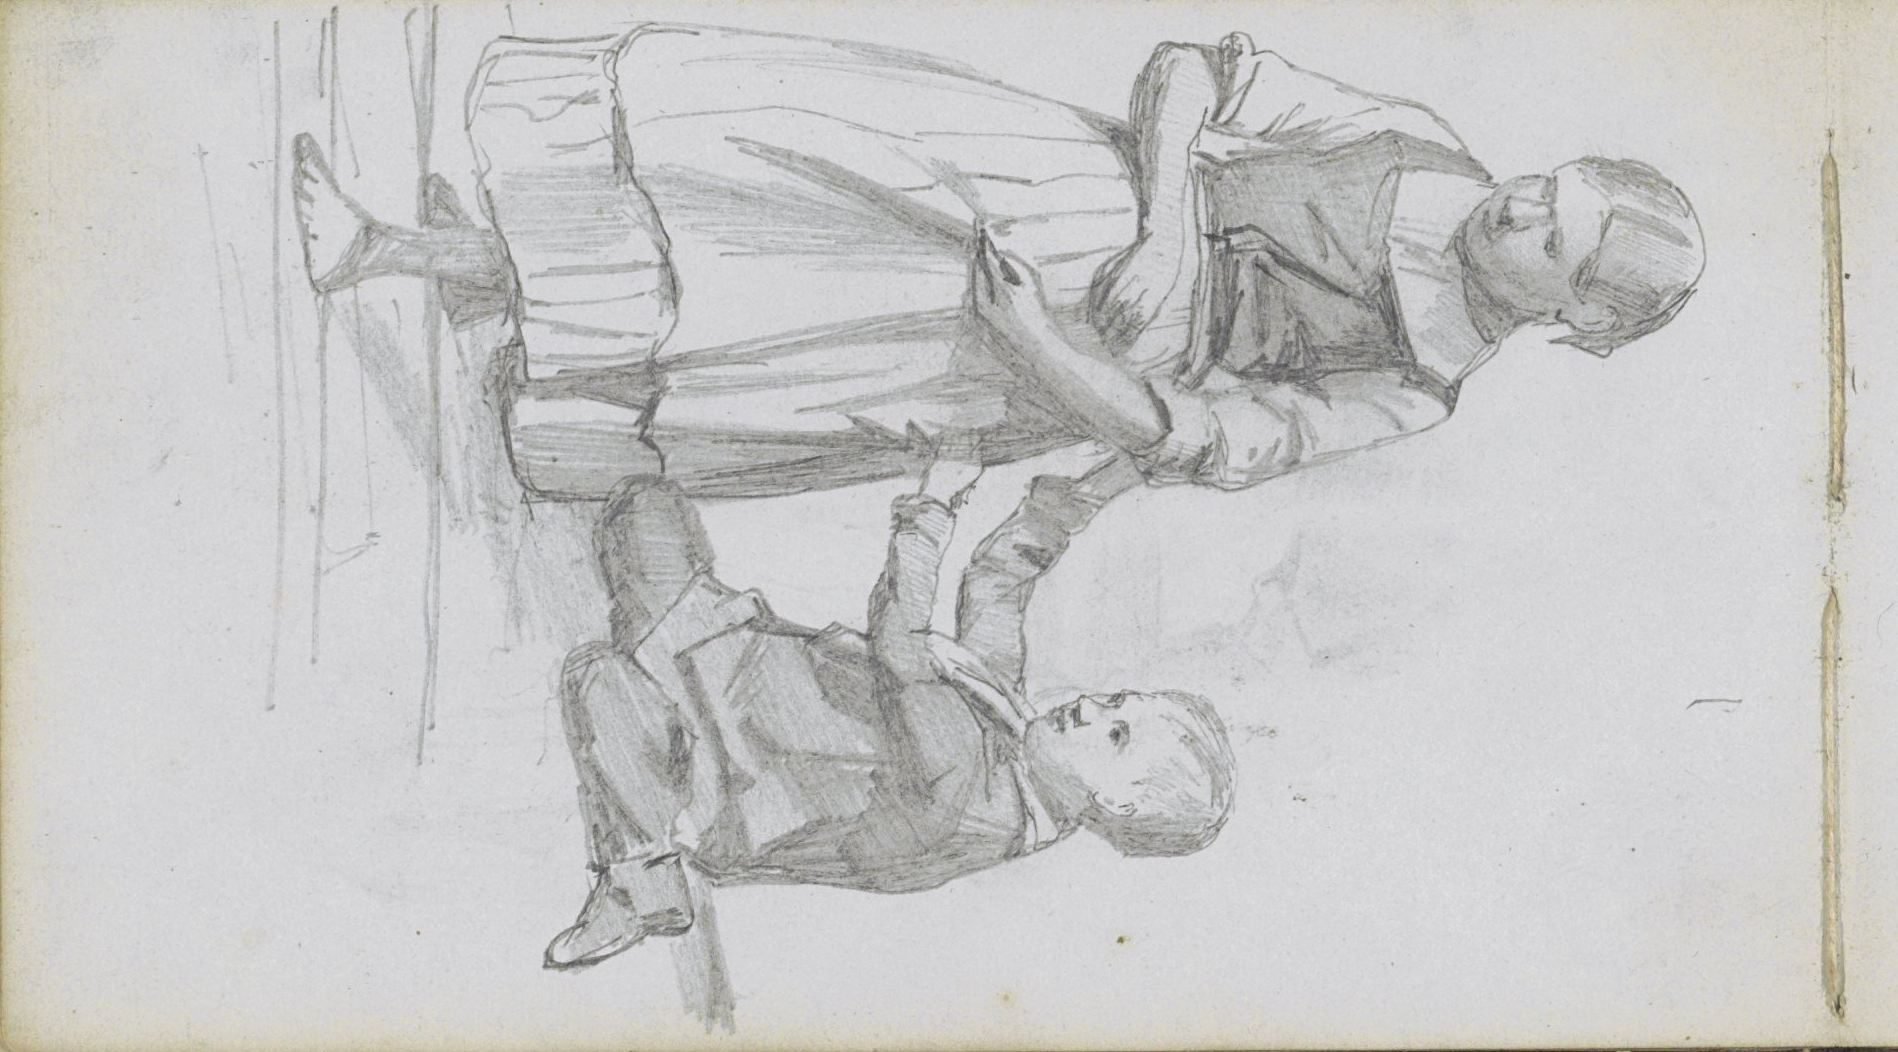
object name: sketchbook leaf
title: Jongen knielend naast een meisje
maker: johan hendrik weissenbruch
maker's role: draughtsman, painter, print maker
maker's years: 1824-1903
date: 1834-1903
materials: paper, pencil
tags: kneeling figure (+ young male (human being)), apron, girl (child between toddler and youth)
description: De jongen houdt het meisje vast aan haar schort en mouw. Blad 37 verso uit een schetsboek met 39 bladen.